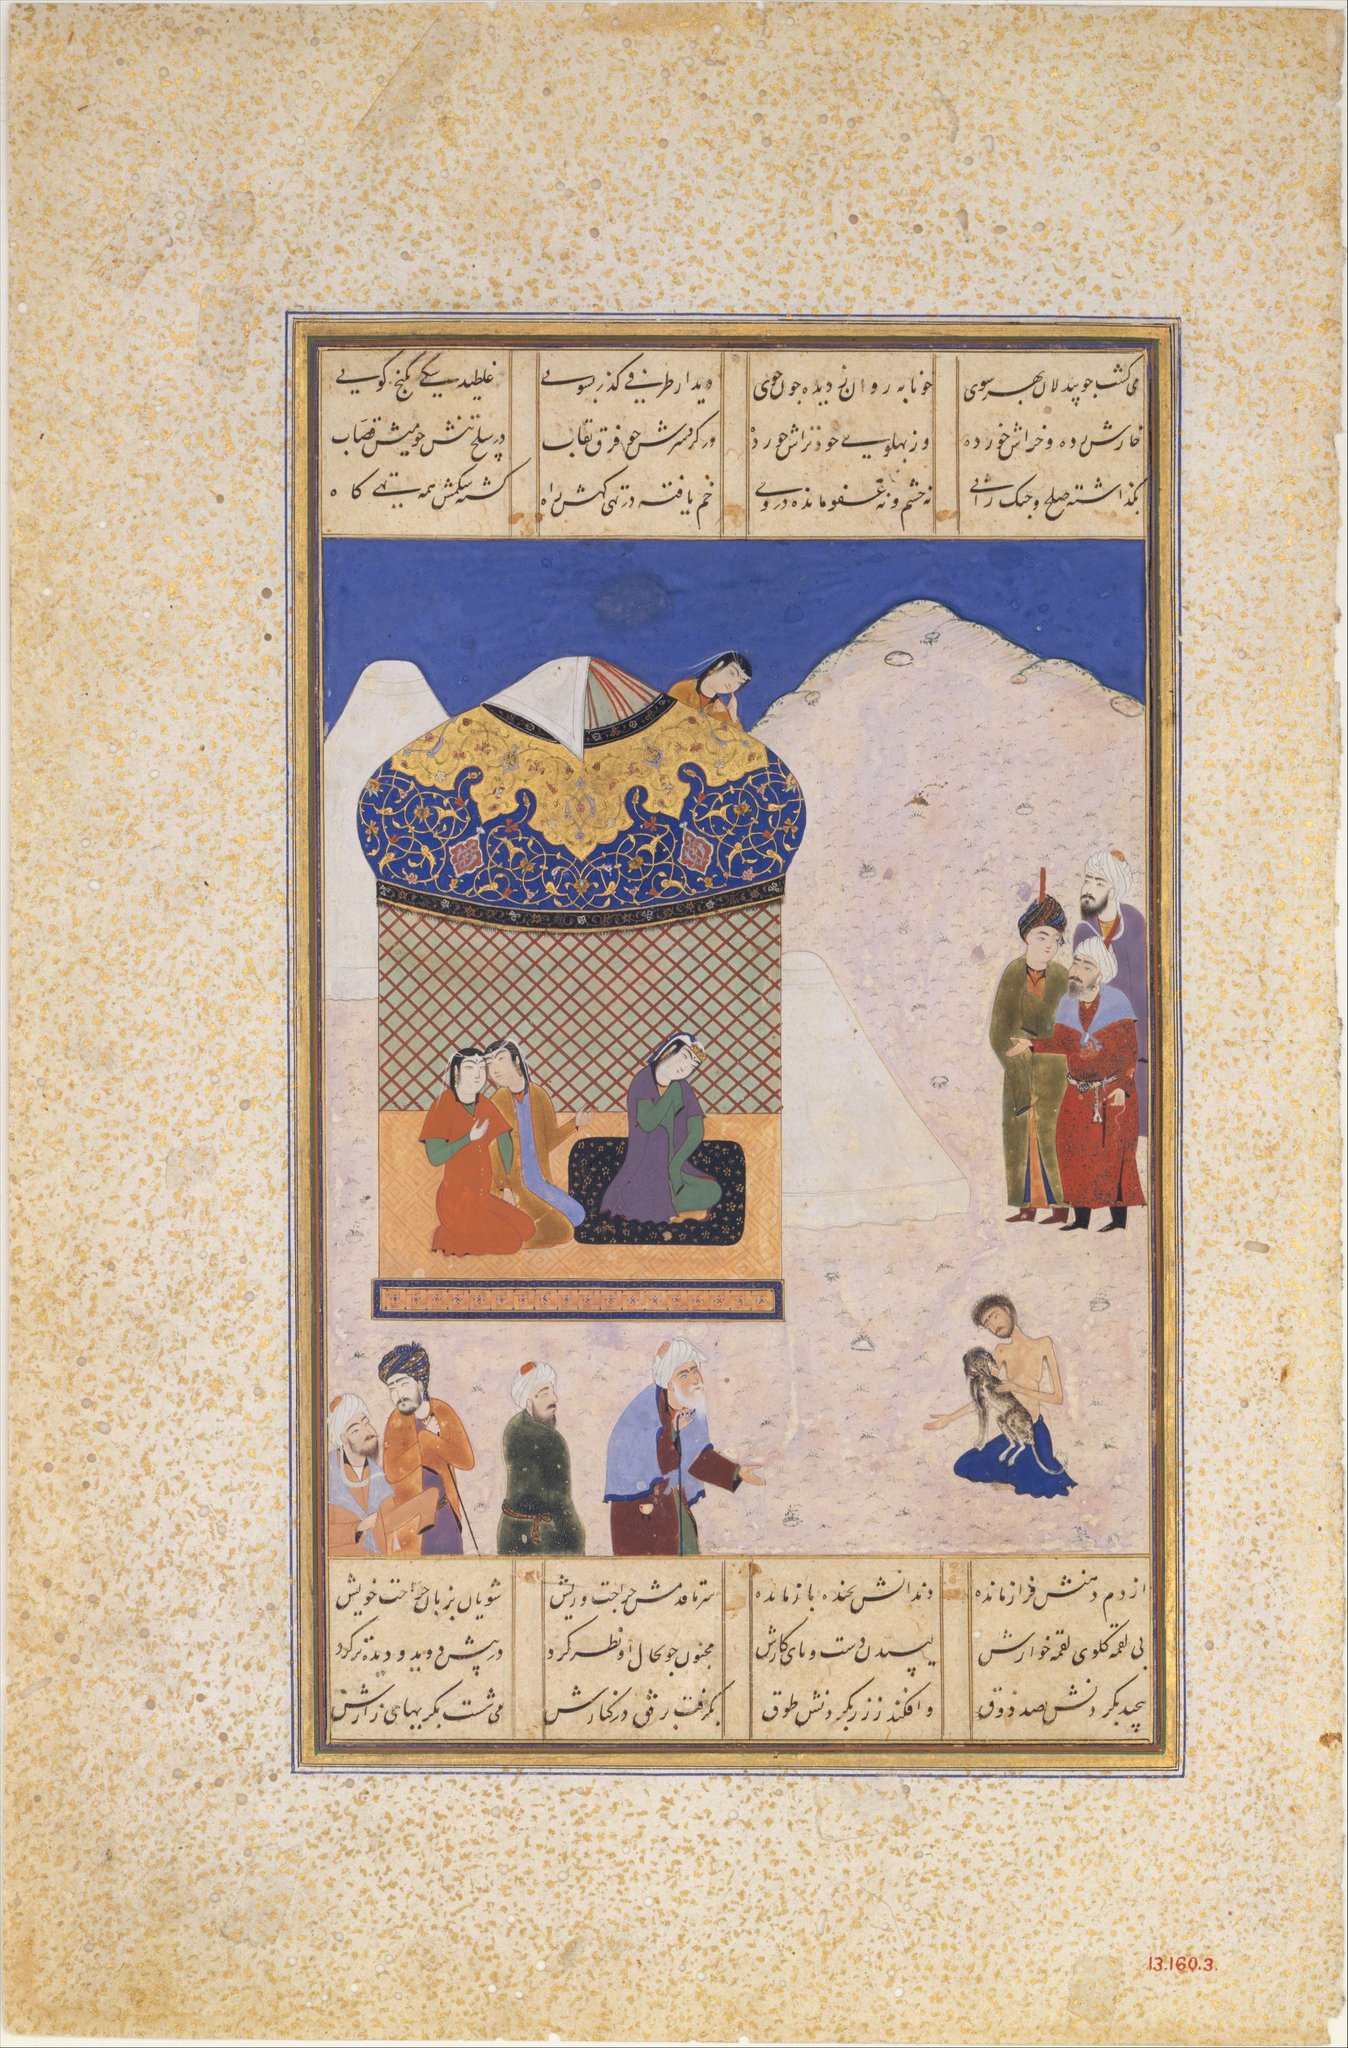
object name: folio from an illustrated manuscript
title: "Laila Visiting Majnun in the Desert", Folio from a Khamsa (Quintet) of Amir Khusrau Dihlavi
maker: ala al-din muhammad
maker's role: calligrapher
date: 1520-1525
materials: gold, ink, paper, watercolor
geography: afghanistan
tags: men,women,dogs,deserts